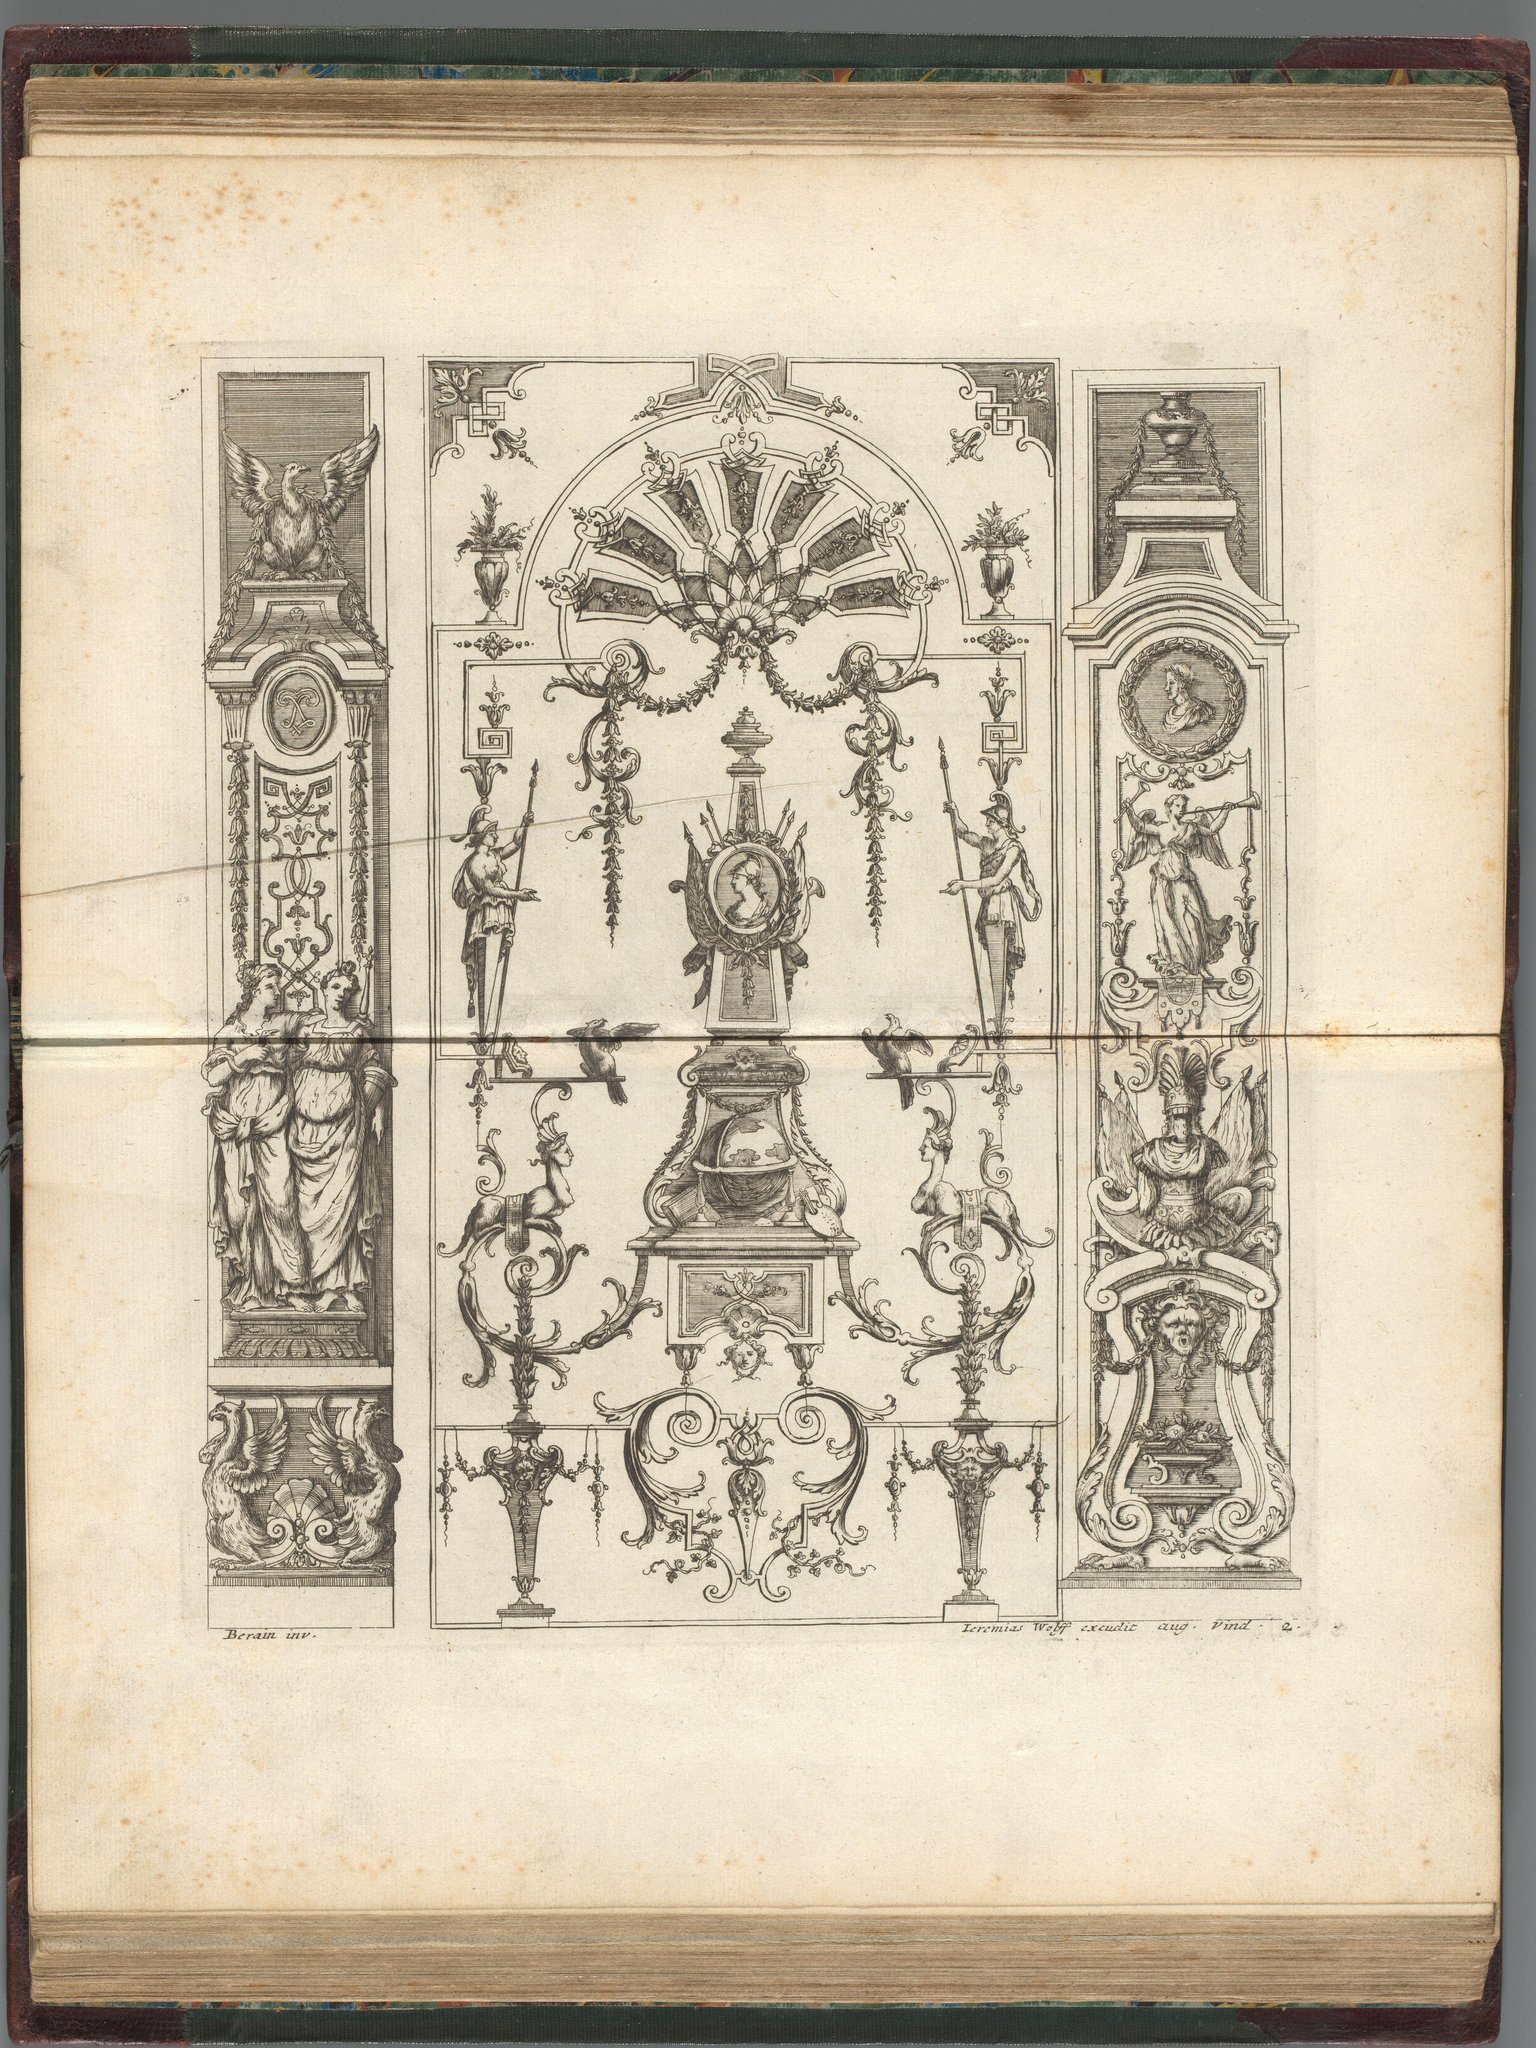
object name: print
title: Compositie met obelisk en wereldbol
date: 1686-1724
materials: paper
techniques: etching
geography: augsburg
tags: obelisk, needle, ornaments ~ art, atlantes ~ architecture, caryatids ~ architecture, globe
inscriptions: number: ‘2.’, signature: ‘Ieremias Wolff excudit aug. Vind.’, signature: ‘Berain inv.’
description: Compositie met obelisk met daaronder een wereldbol geflankeerd door een kariatide en atlant met helm en speer, twee vogels en twee sfinxen. Aan weerszijden een paneel met links twee vrouwen en rechts een engel die op een bazoen blaast en een harnas. Prent maakt deel uit van een album. Hoogstwaarschijnlijk gespiegelde kopie naar Frans origineel.